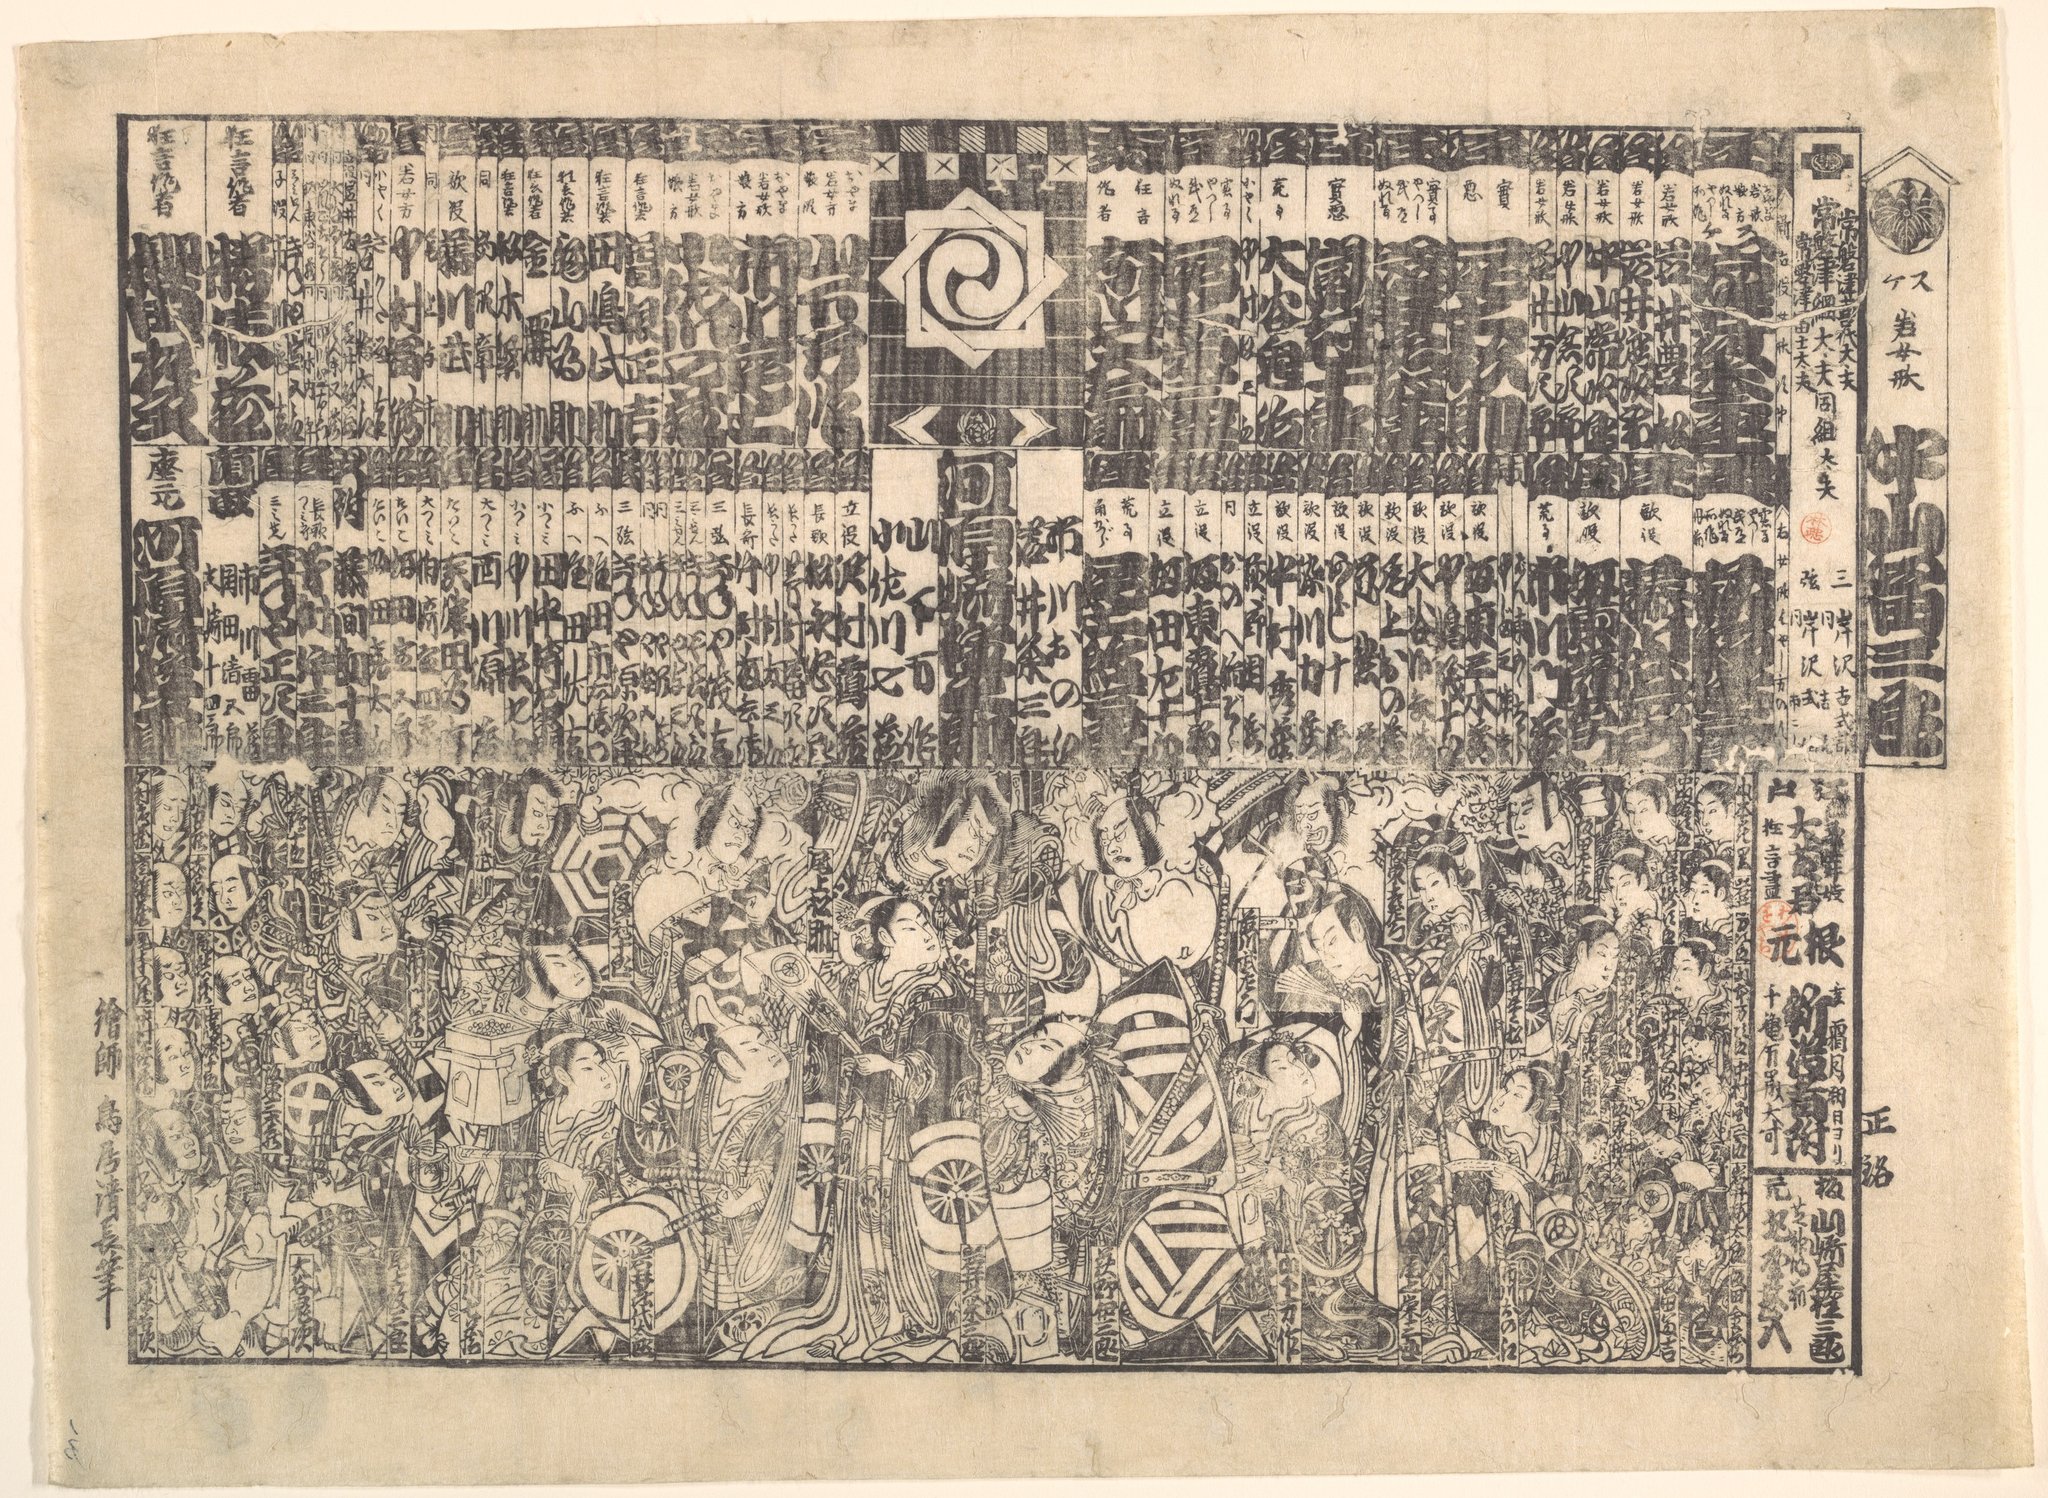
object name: woodblock print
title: Program for Kawarazaki Theater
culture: japanese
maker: torii kiyonaga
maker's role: artist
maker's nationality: japanese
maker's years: 1752-1815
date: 1800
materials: ink, paper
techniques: woodblock print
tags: theatre,actors